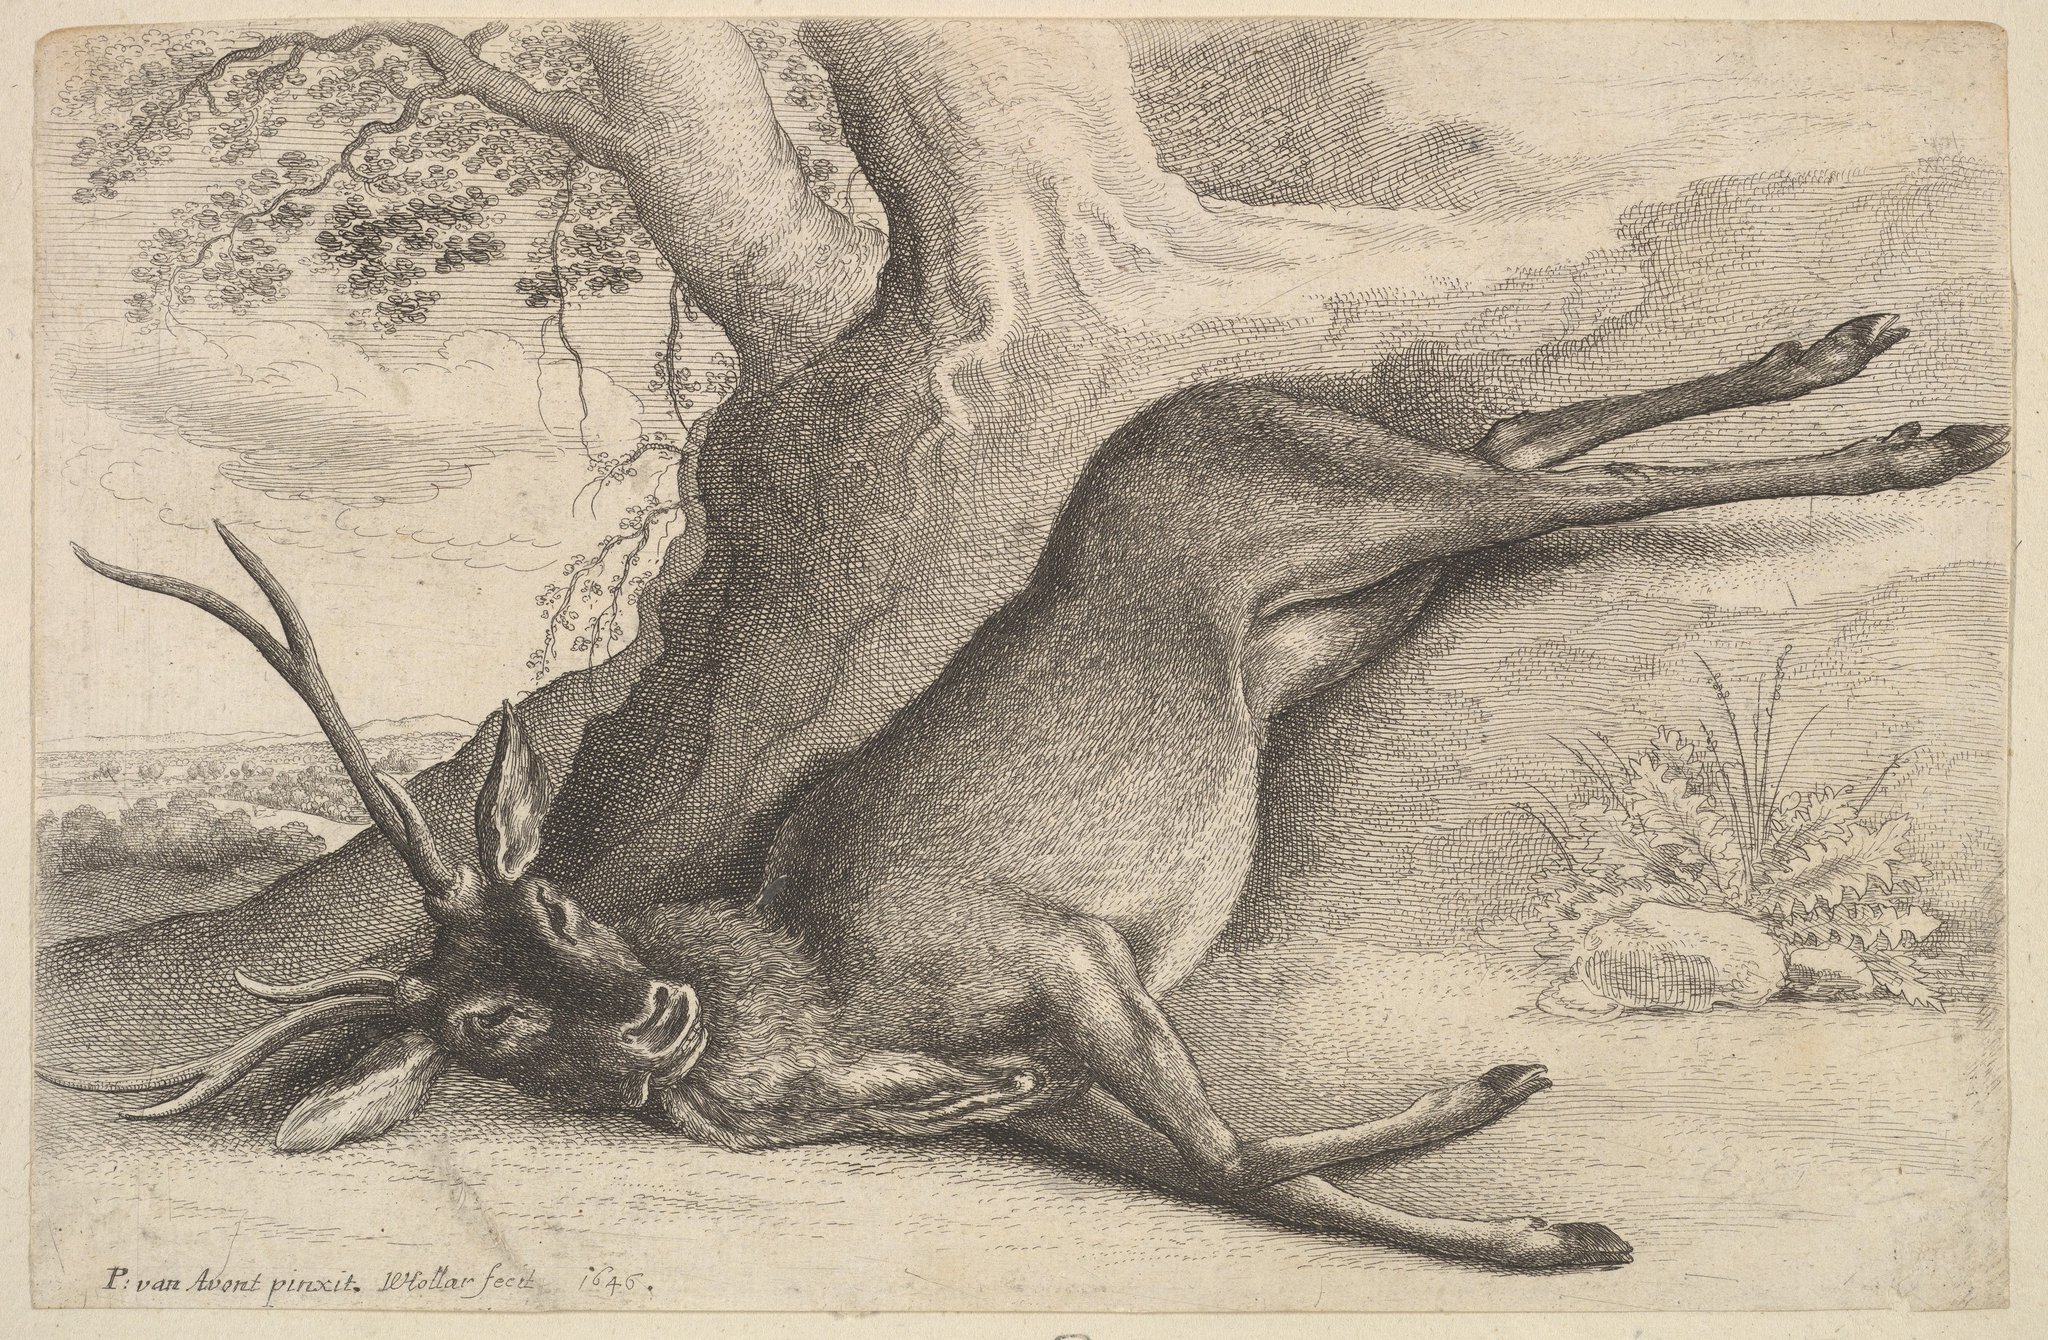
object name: print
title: Dead stag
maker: wenceslaus hollar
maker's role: artist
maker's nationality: bohemian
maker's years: 1607-1677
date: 1646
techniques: etching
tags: deer